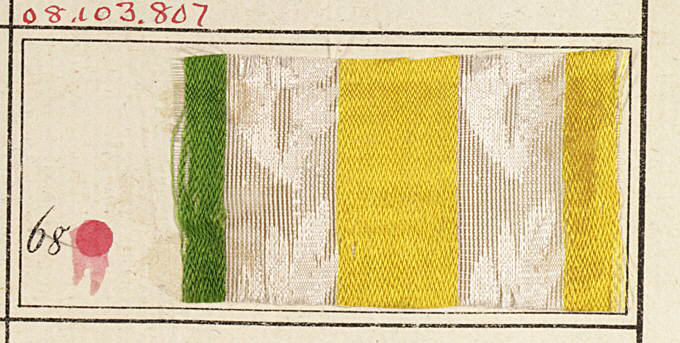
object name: ribbon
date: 1701-1900